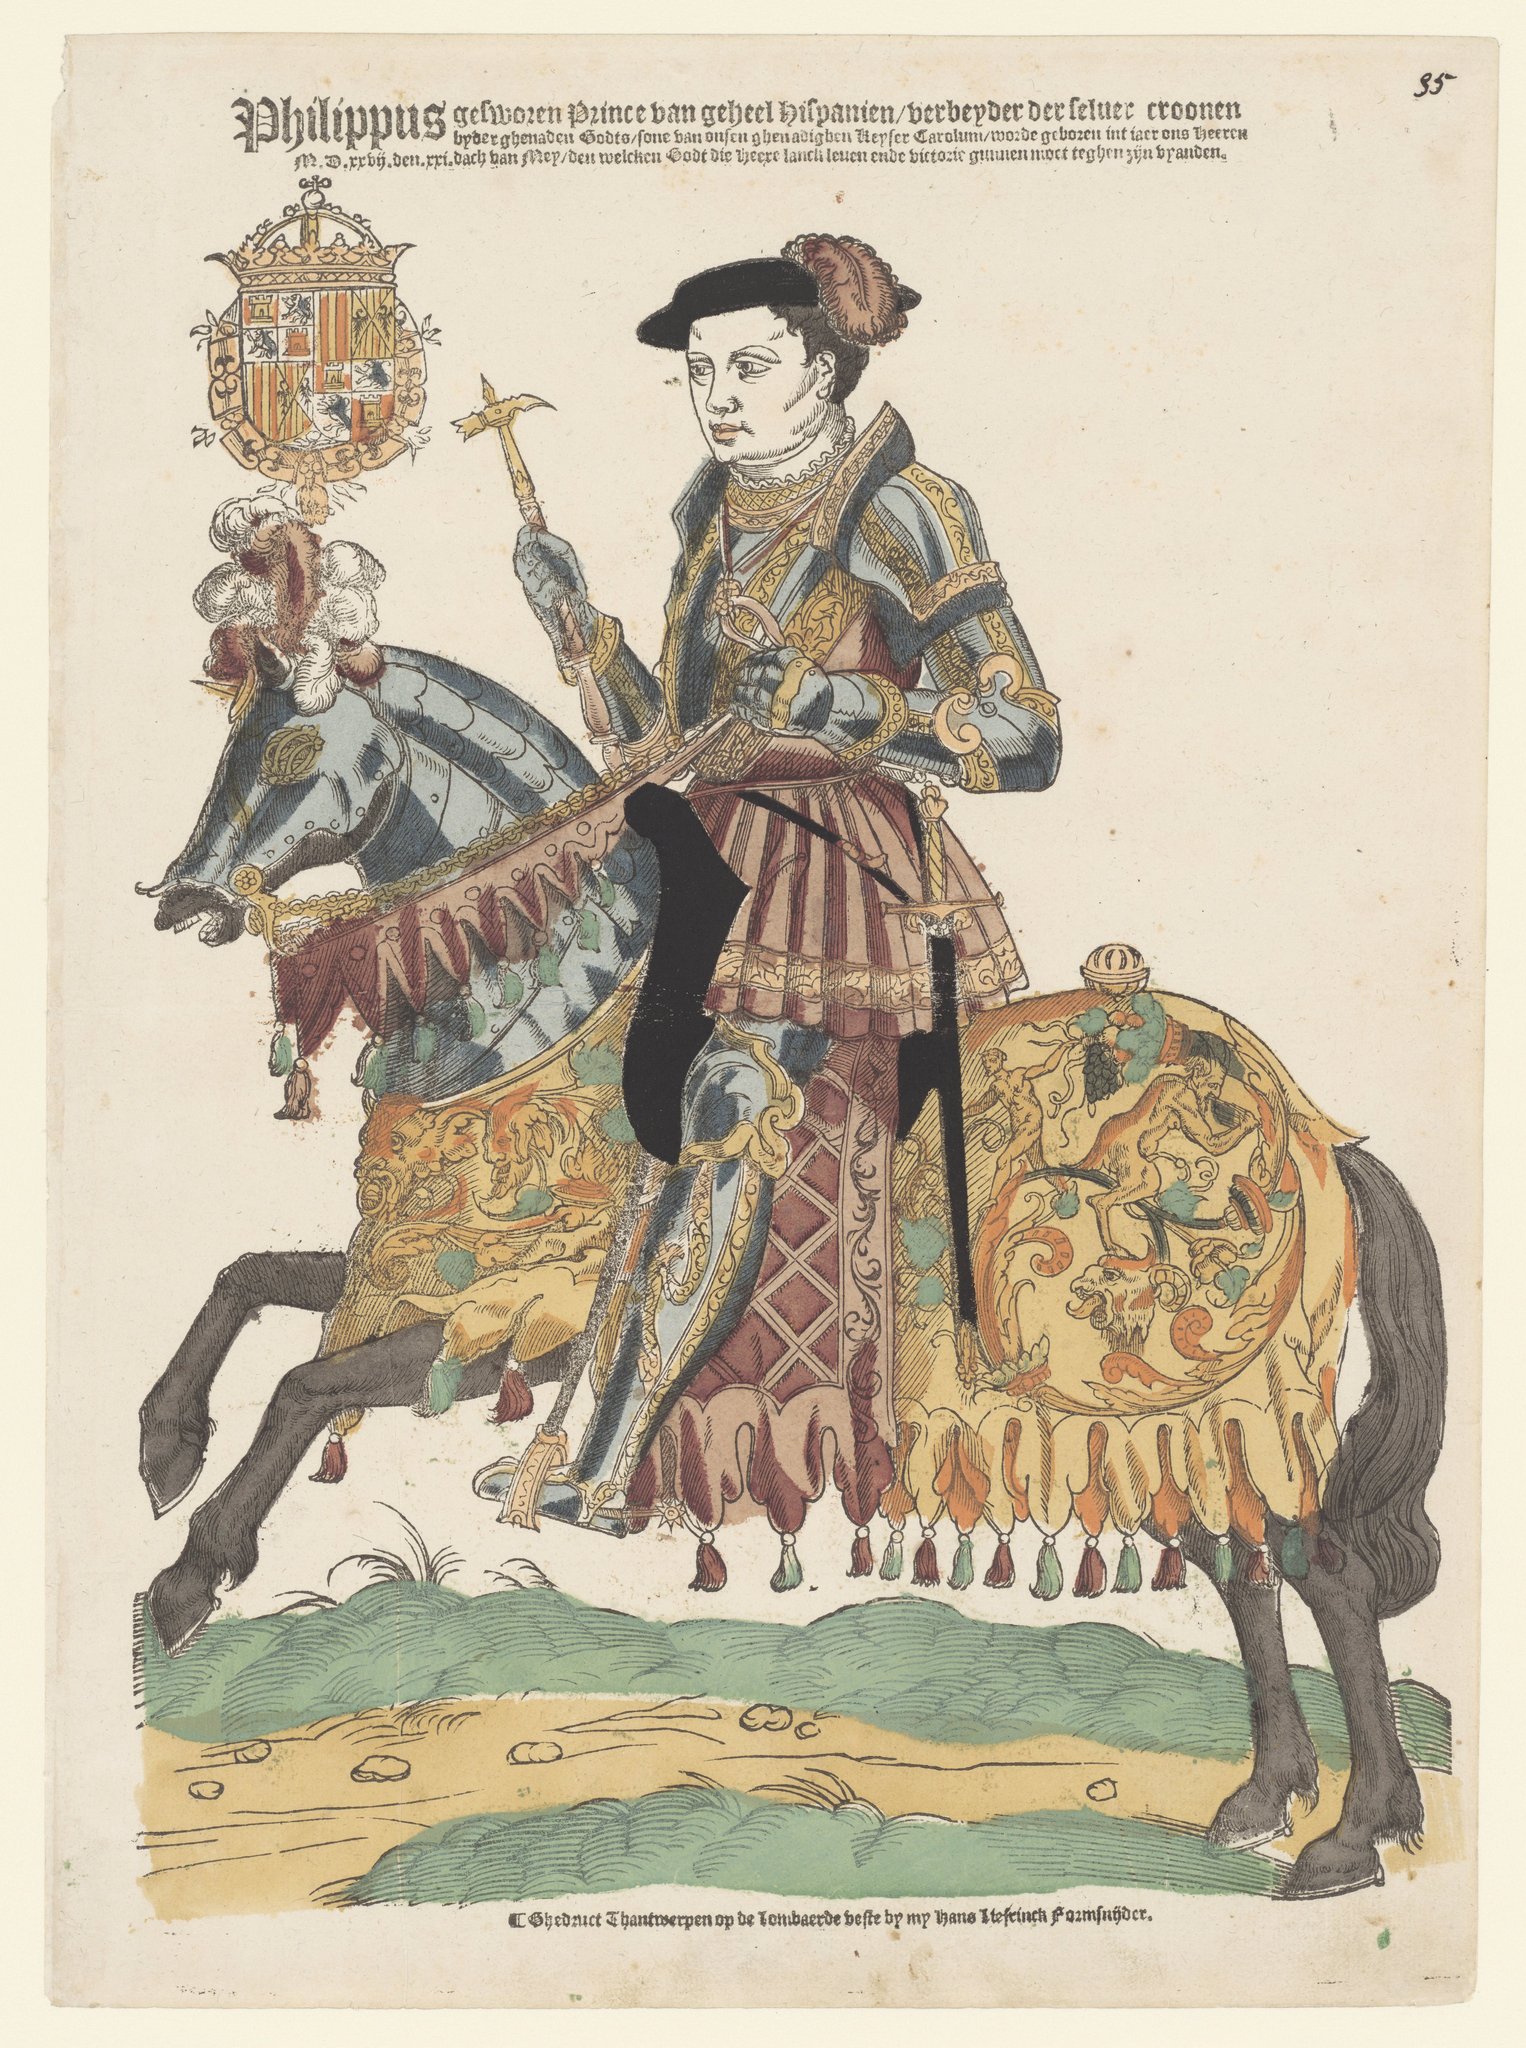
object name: print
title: Portret van Filips II te paard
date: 1539-1556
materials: paper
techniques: hand coloring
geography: antwerp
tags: philip ii of spain, equestrian state-portrait, historical persons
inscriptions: address: ‘Ghedruct Thantwerpen op de Lombaerde veste by my Hans Liefrinck Formsnijder’, number: ‘35’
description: Filips II (1527-1598), zoon en opvolger van Karel V, geboren in Spanje, voor het eerst in de Nederlanden in 1549 bij zijn feestelijke intrede in Antwerpen. Ruiter in harnas op een gepantserd paard in galop naar links. Zijn wapen met de Orde van het Gulden Vlies linksboven.